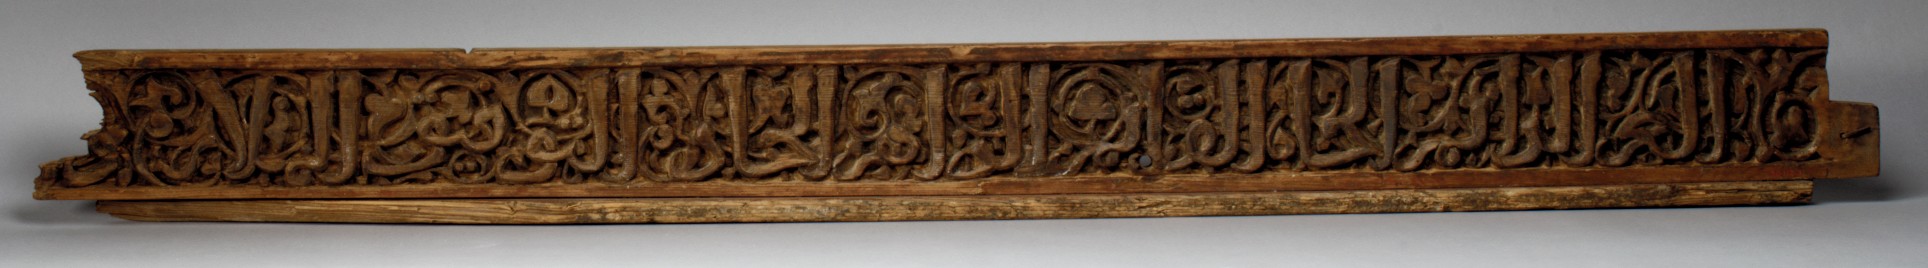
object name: panel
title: Panel with Inscription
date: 1201-1300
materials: wood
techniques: carving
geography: egypt or syria